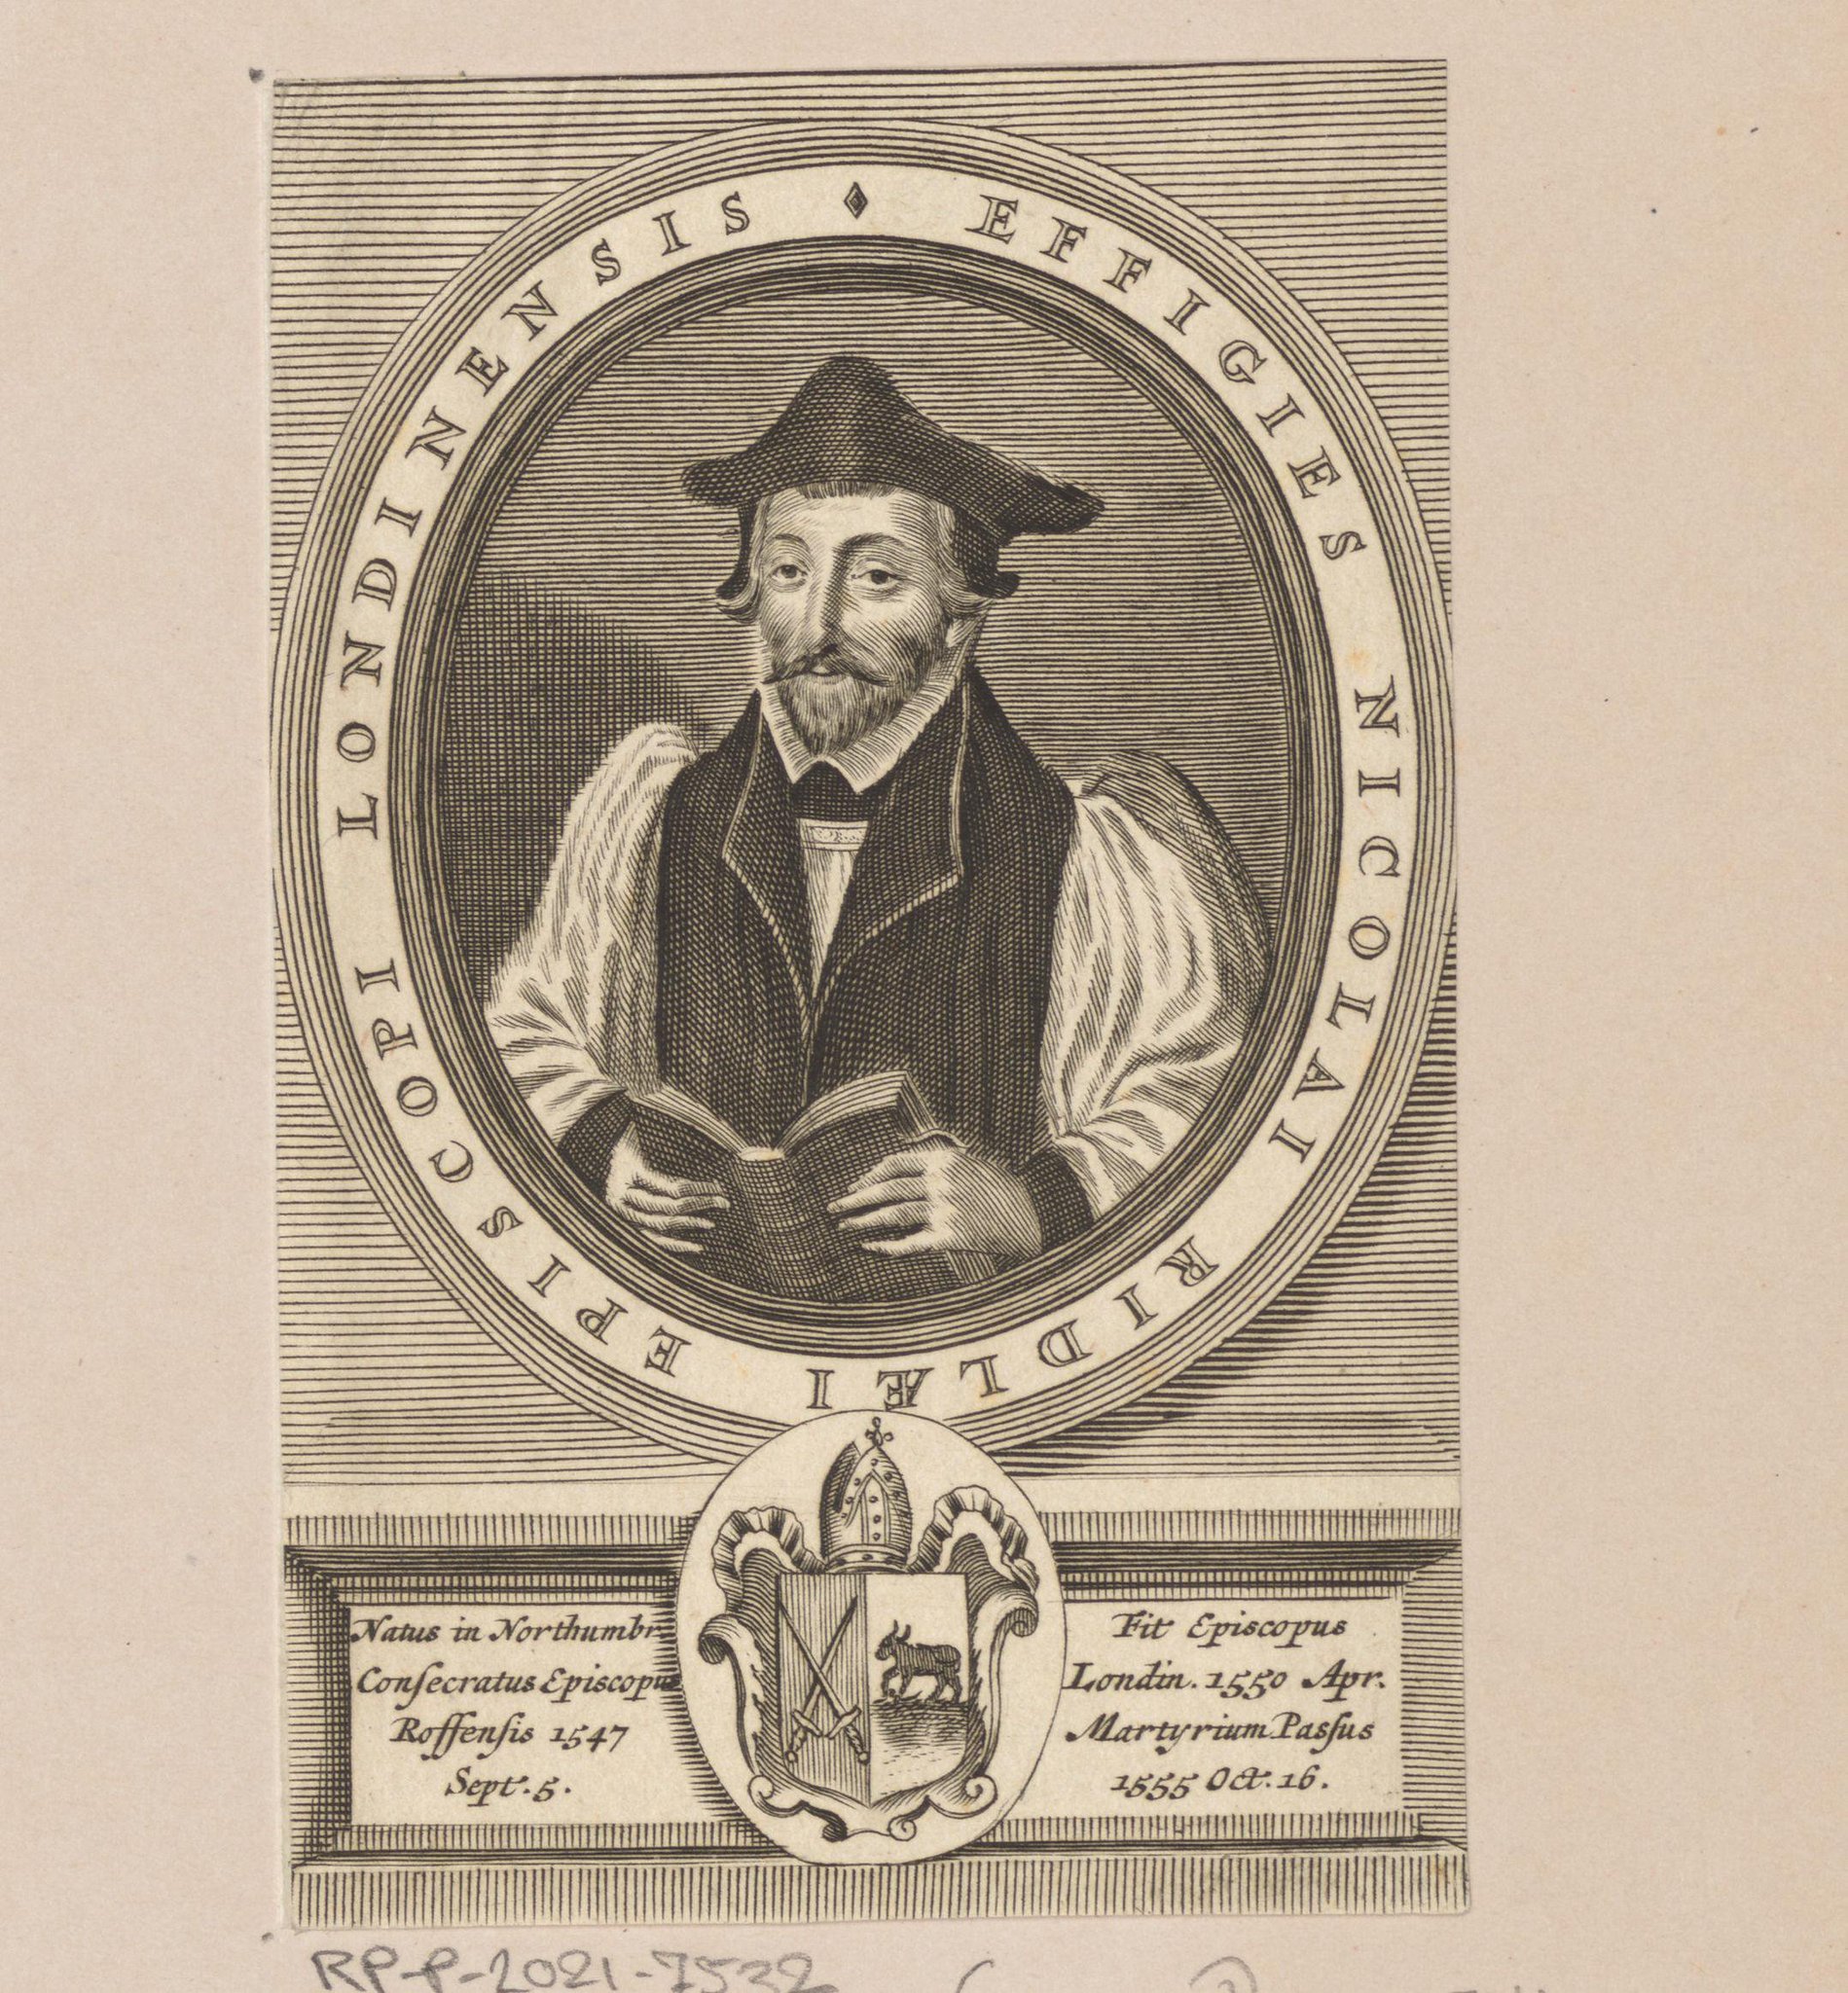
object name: print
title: Portret van Nicolas Ridley, bisschop van Londen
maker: Anonymous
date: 1650-1749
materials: paper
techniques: engraving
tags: historical persons, armorial bearing, heraldry